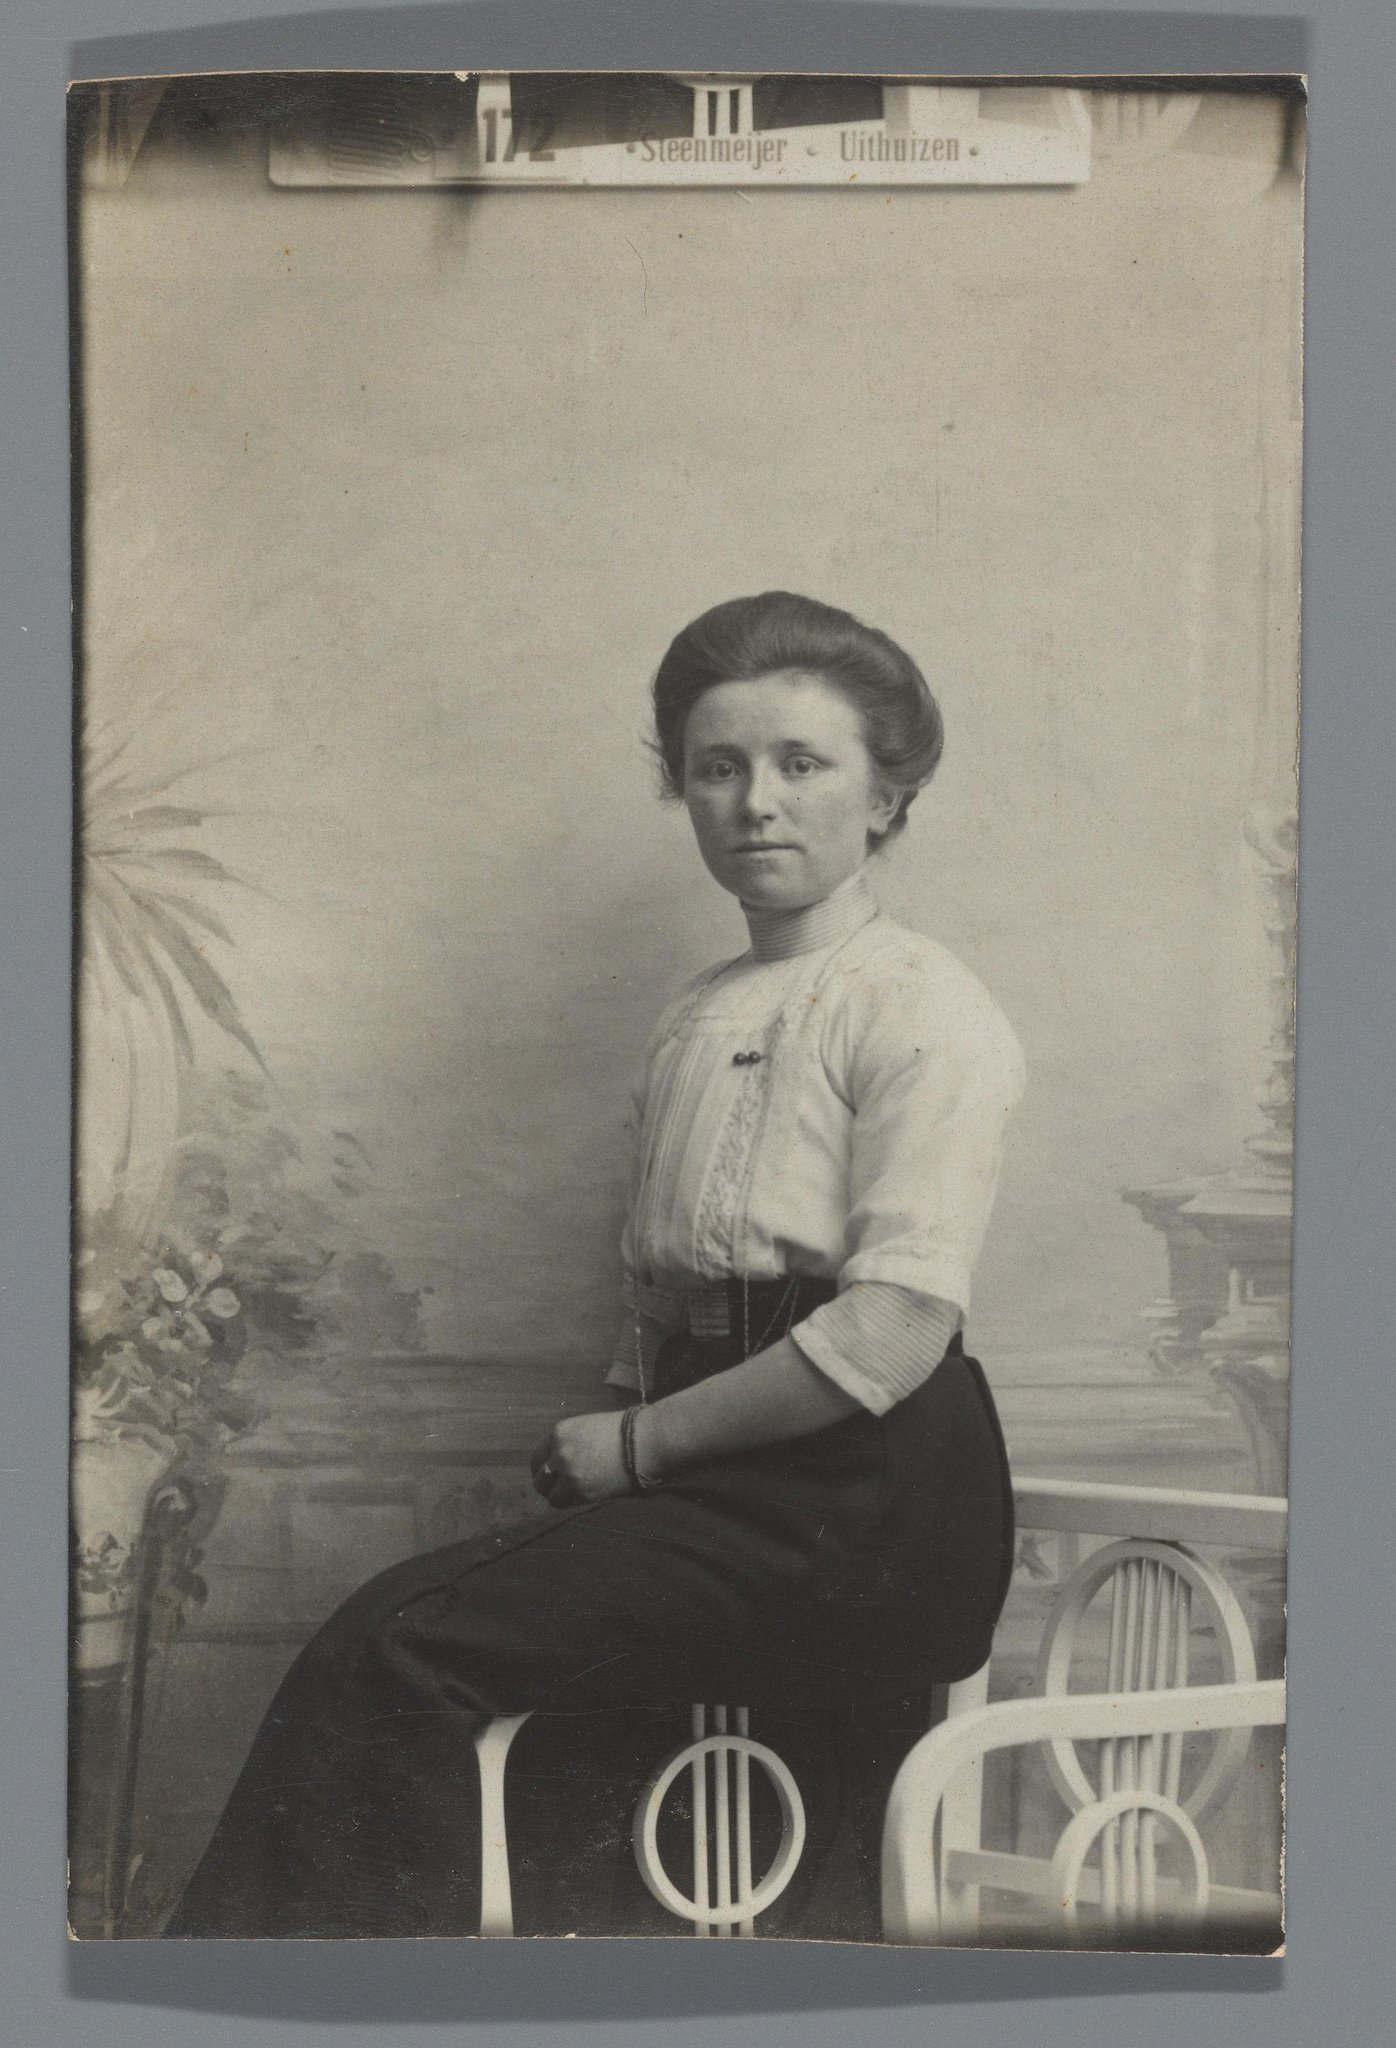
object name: snapshot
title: Portret van een vrouw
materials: photographic support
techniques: gelatin silver print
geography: groningen